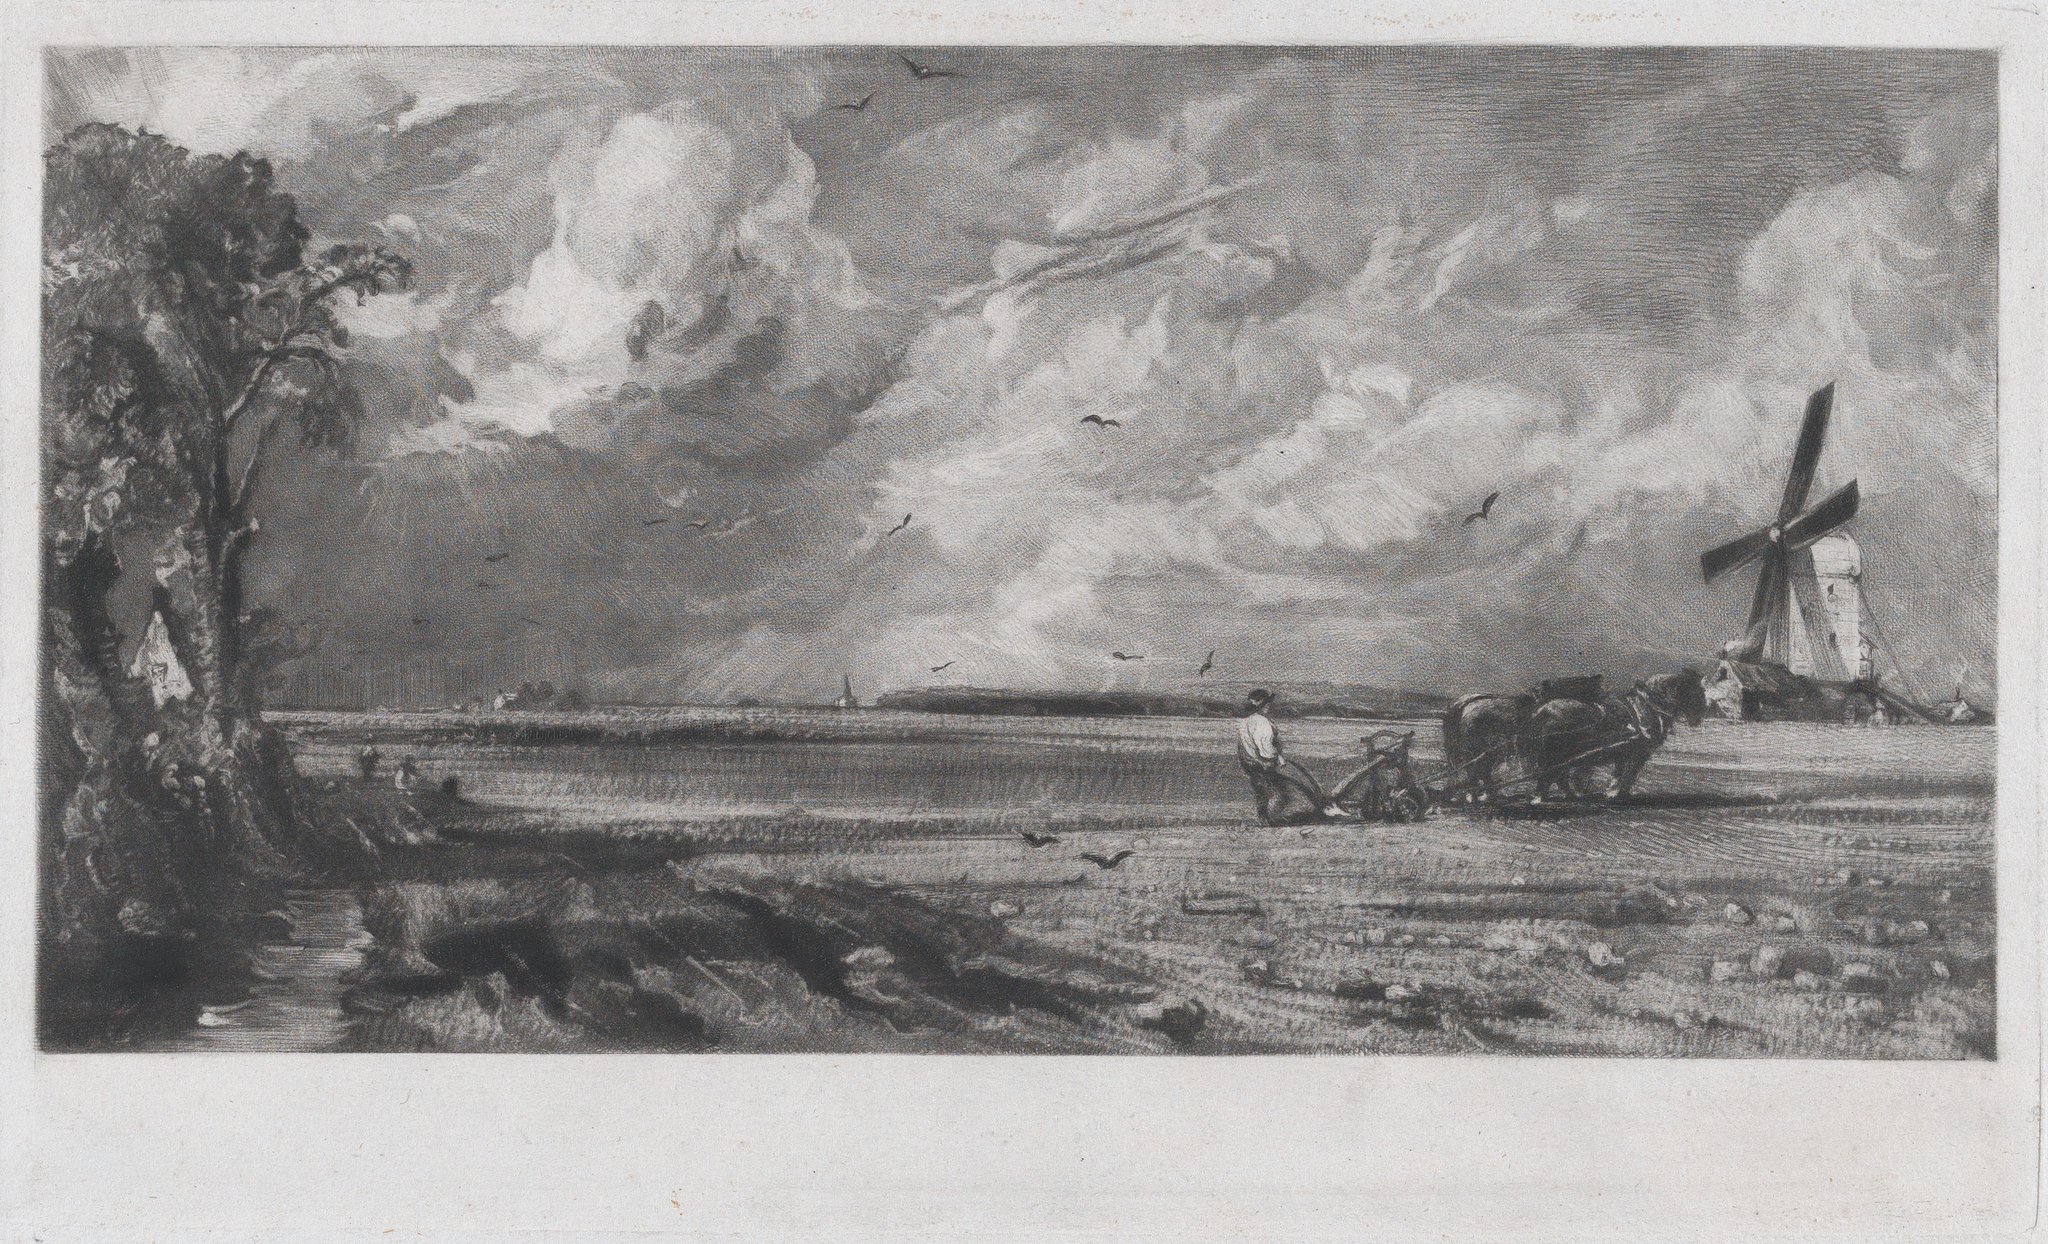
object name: print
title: Spring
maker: david lucas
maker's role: artist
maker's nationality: british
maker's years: 1802-1881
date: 1829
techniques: mezzotint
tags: human figures,animals,windmills,landscapes,spring